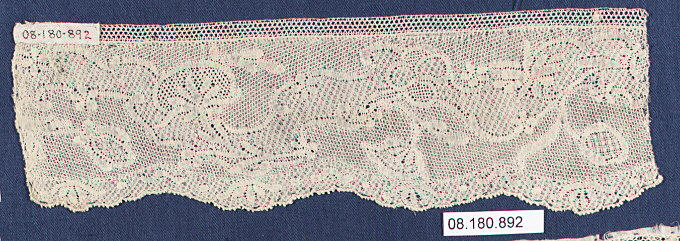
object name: border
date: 1701-1800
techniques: embroidery